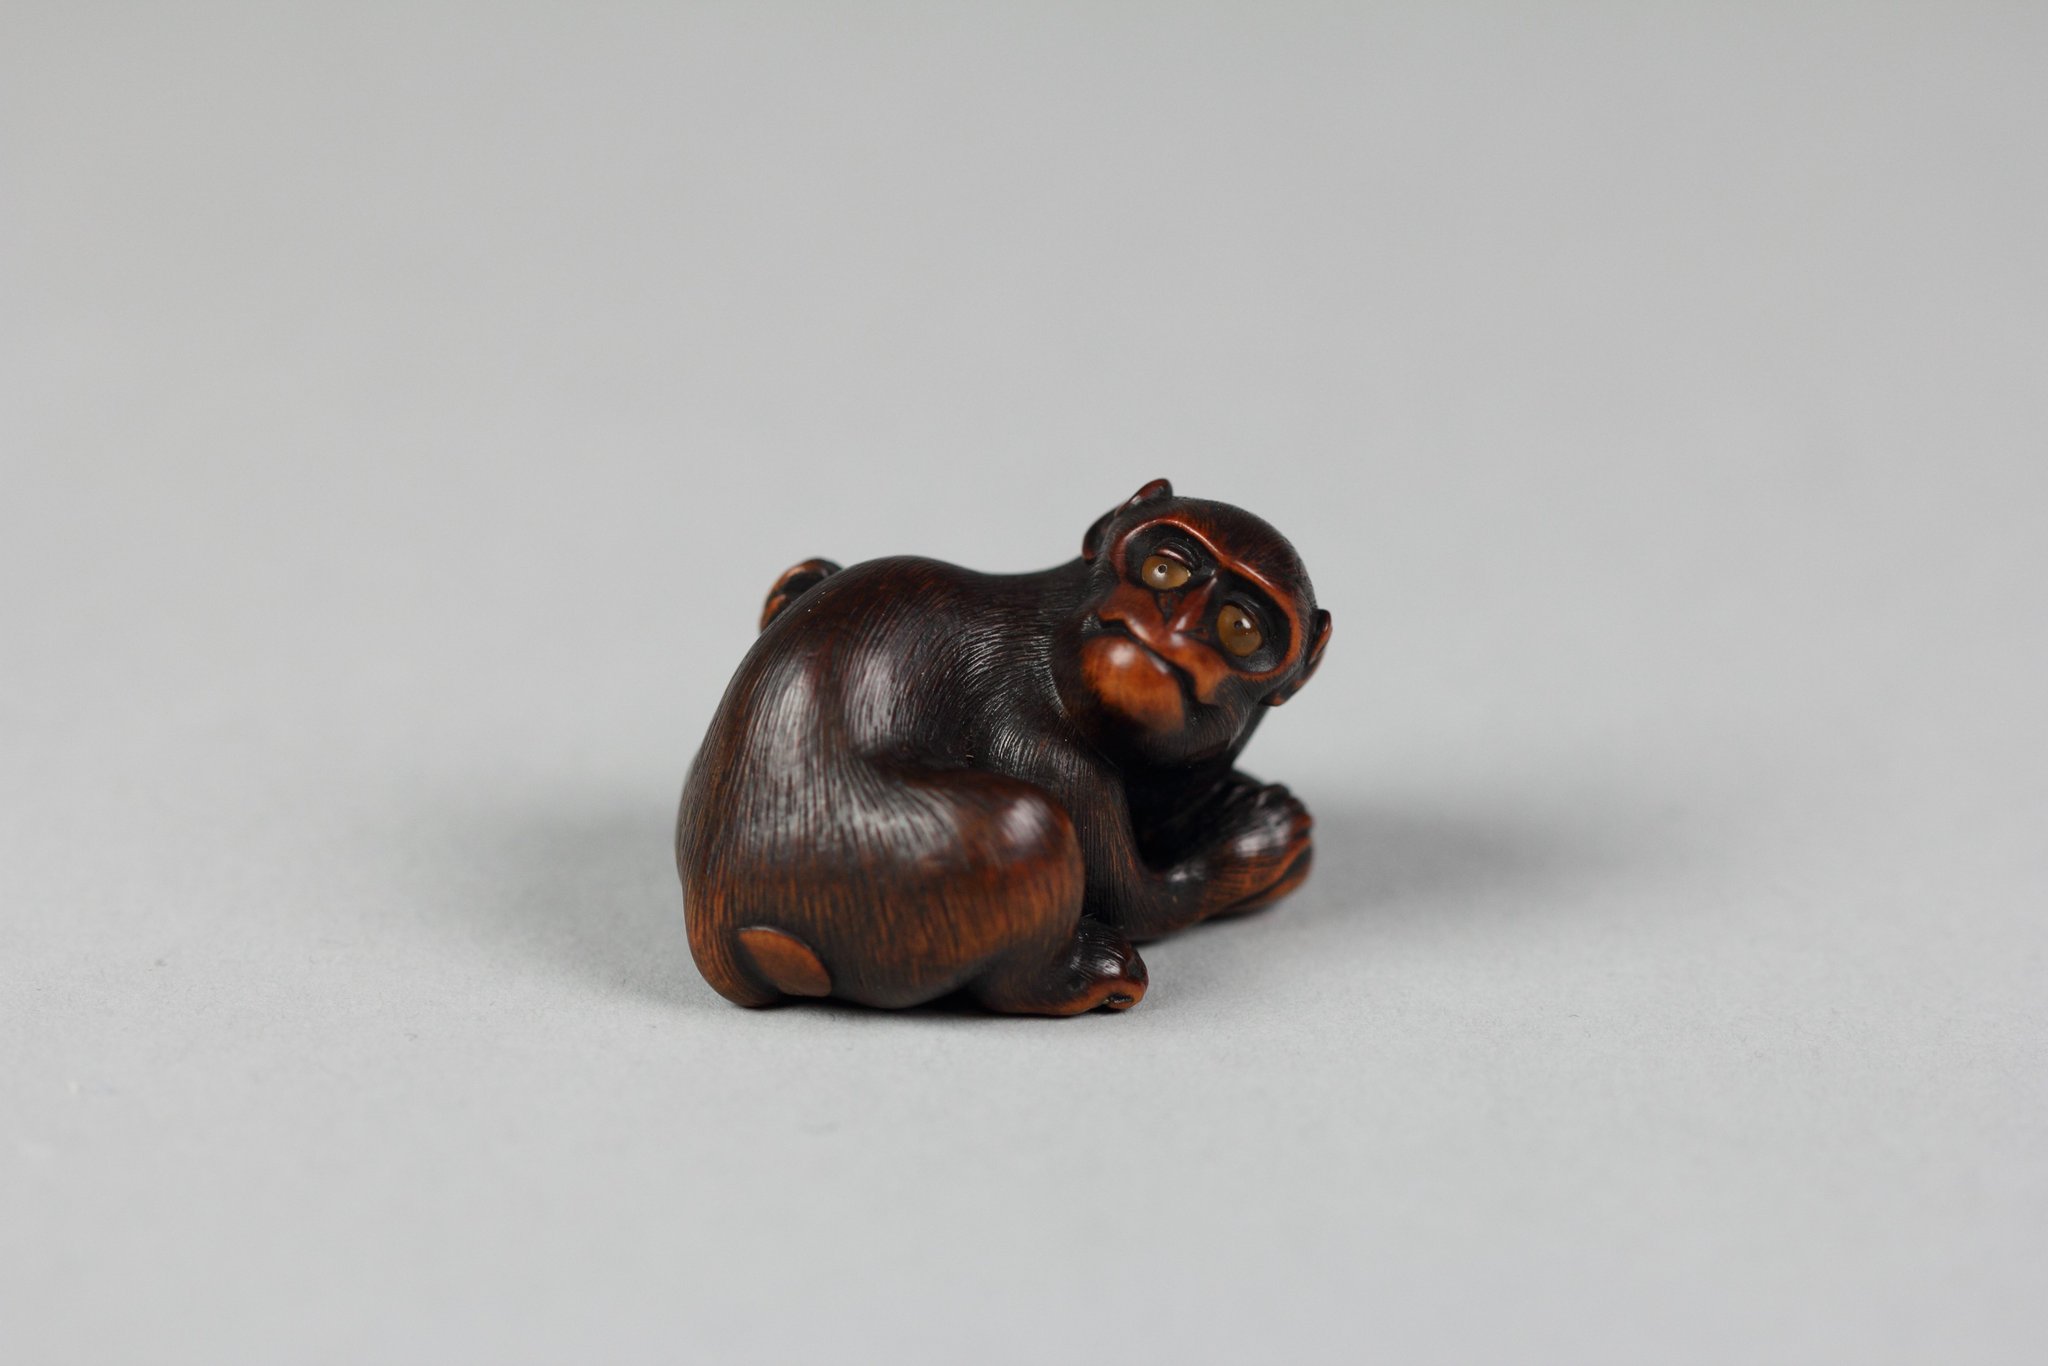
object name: netsuke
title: Netsuke of Monkey Scratching His Back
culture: japanese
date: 1801-1900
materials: wood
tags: monkeys